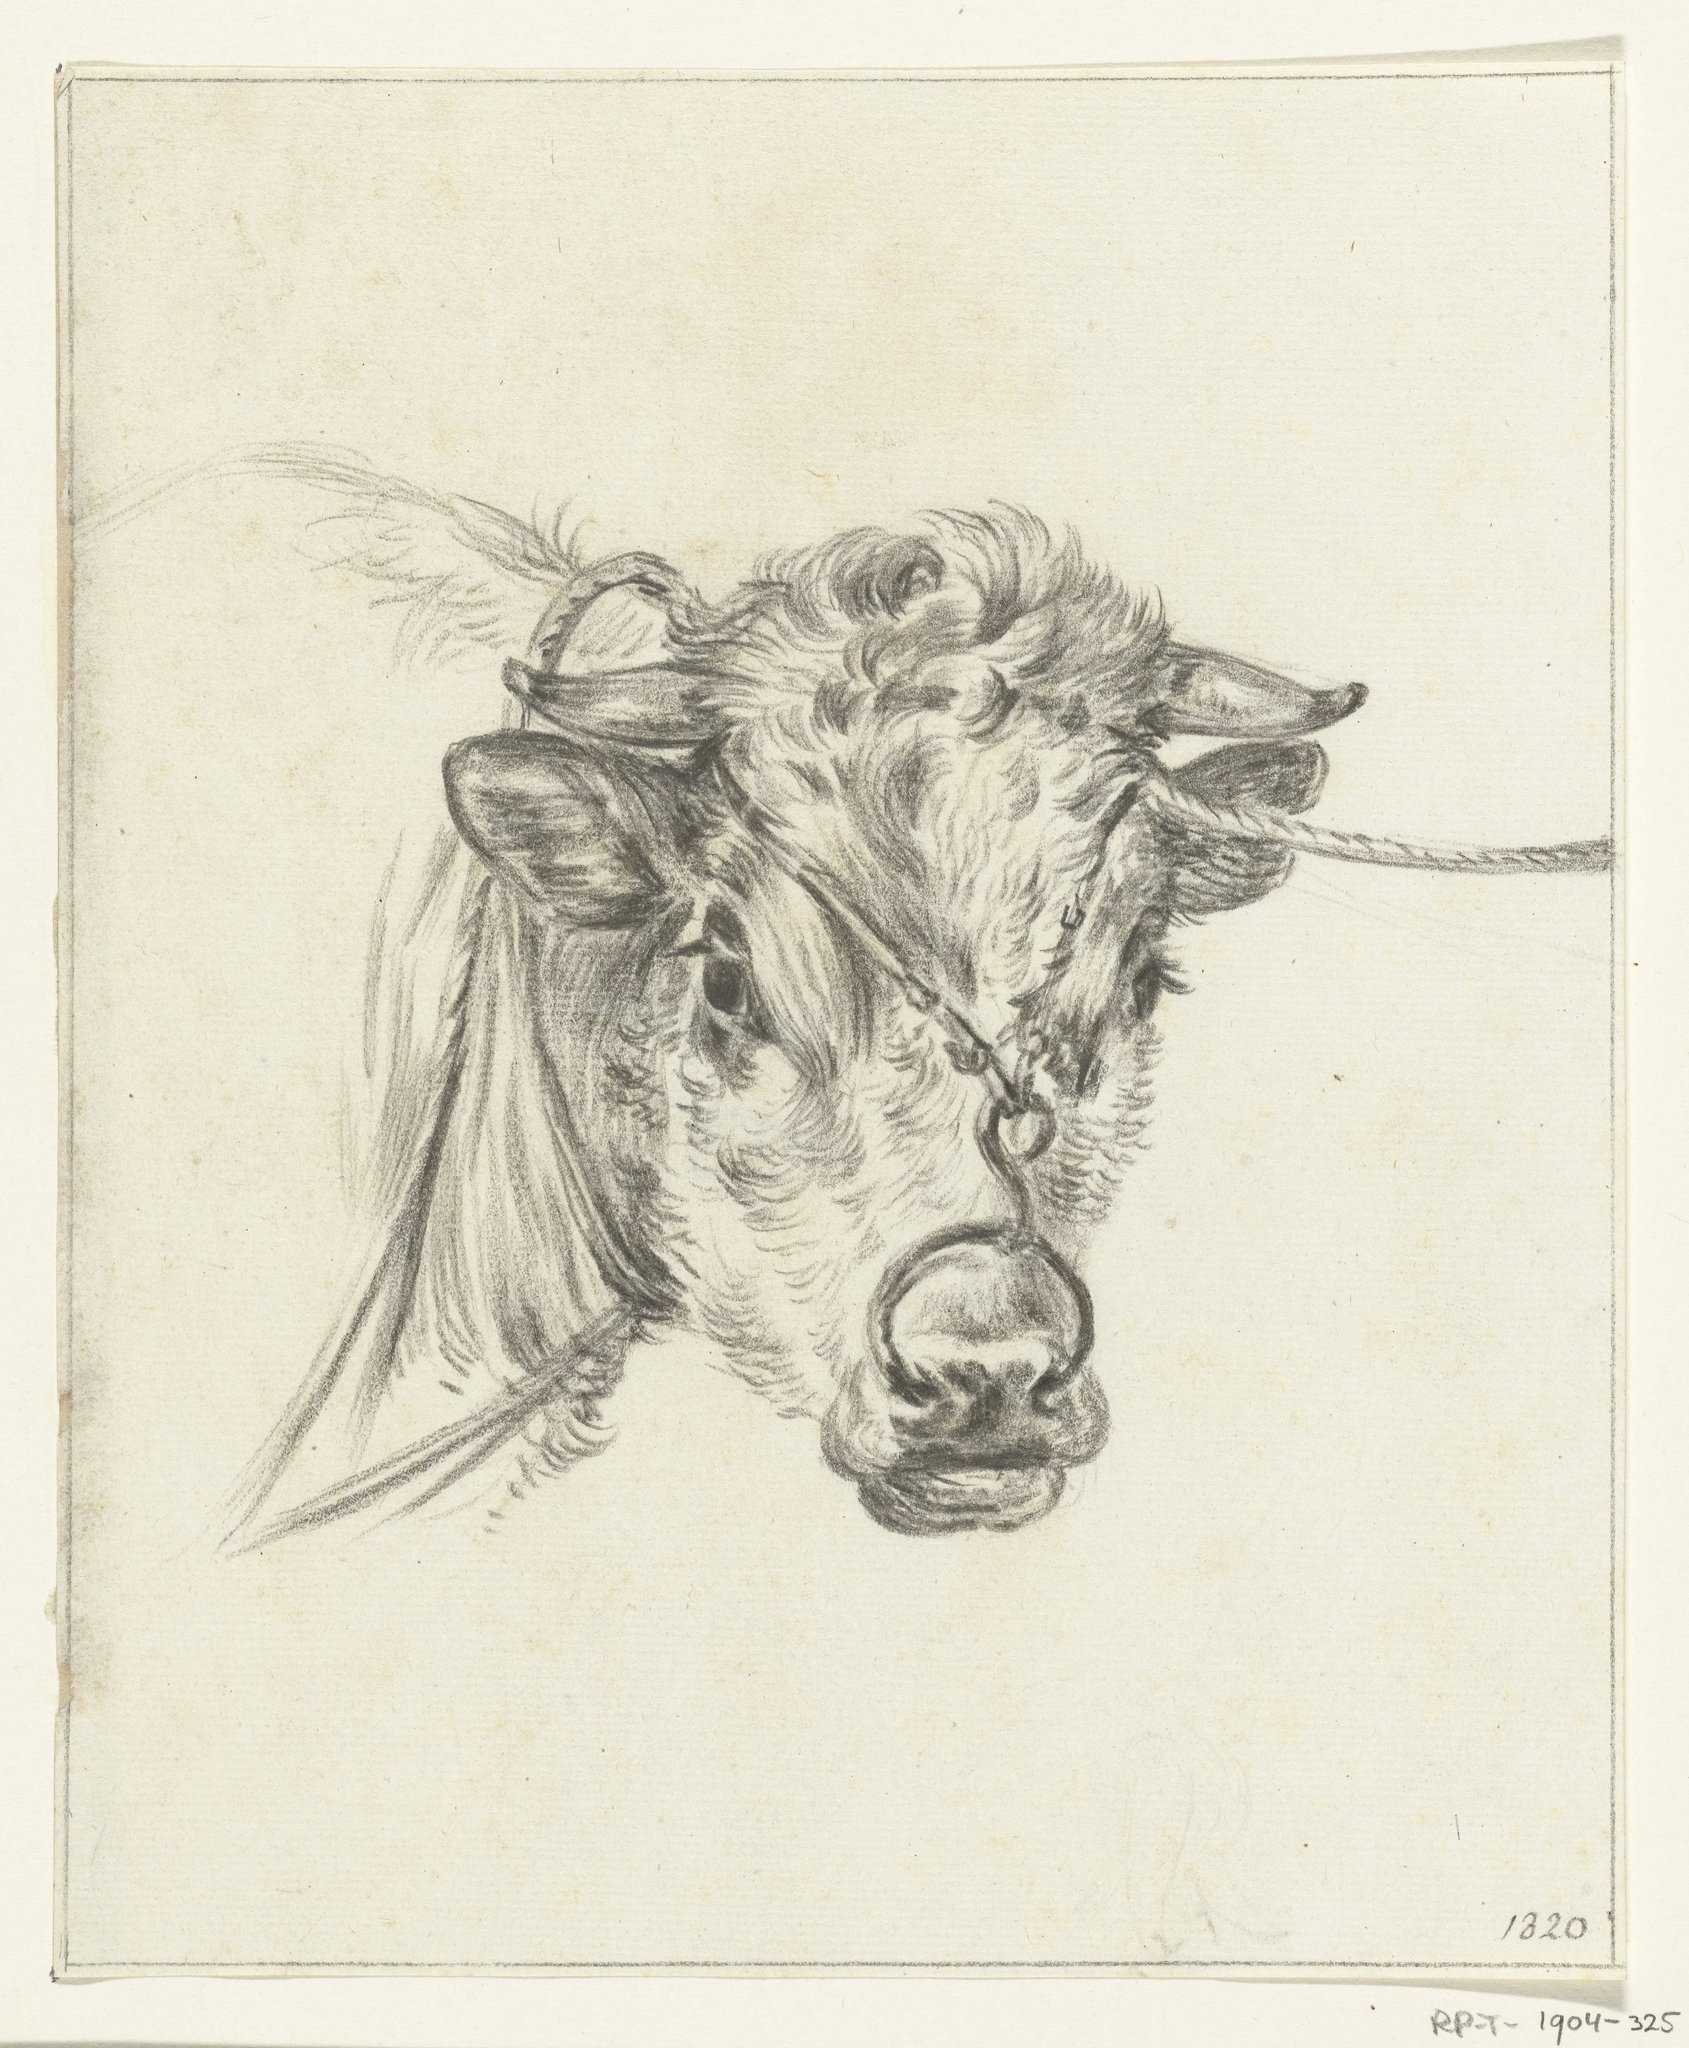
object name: drawing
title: Kop van een koe, met een ring door de neus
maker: jean bernard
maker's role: draughtsman, print maker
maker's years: 1765-1833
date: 1820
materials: chalk, paper, pencil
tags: cow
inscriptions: date: ‘1820’